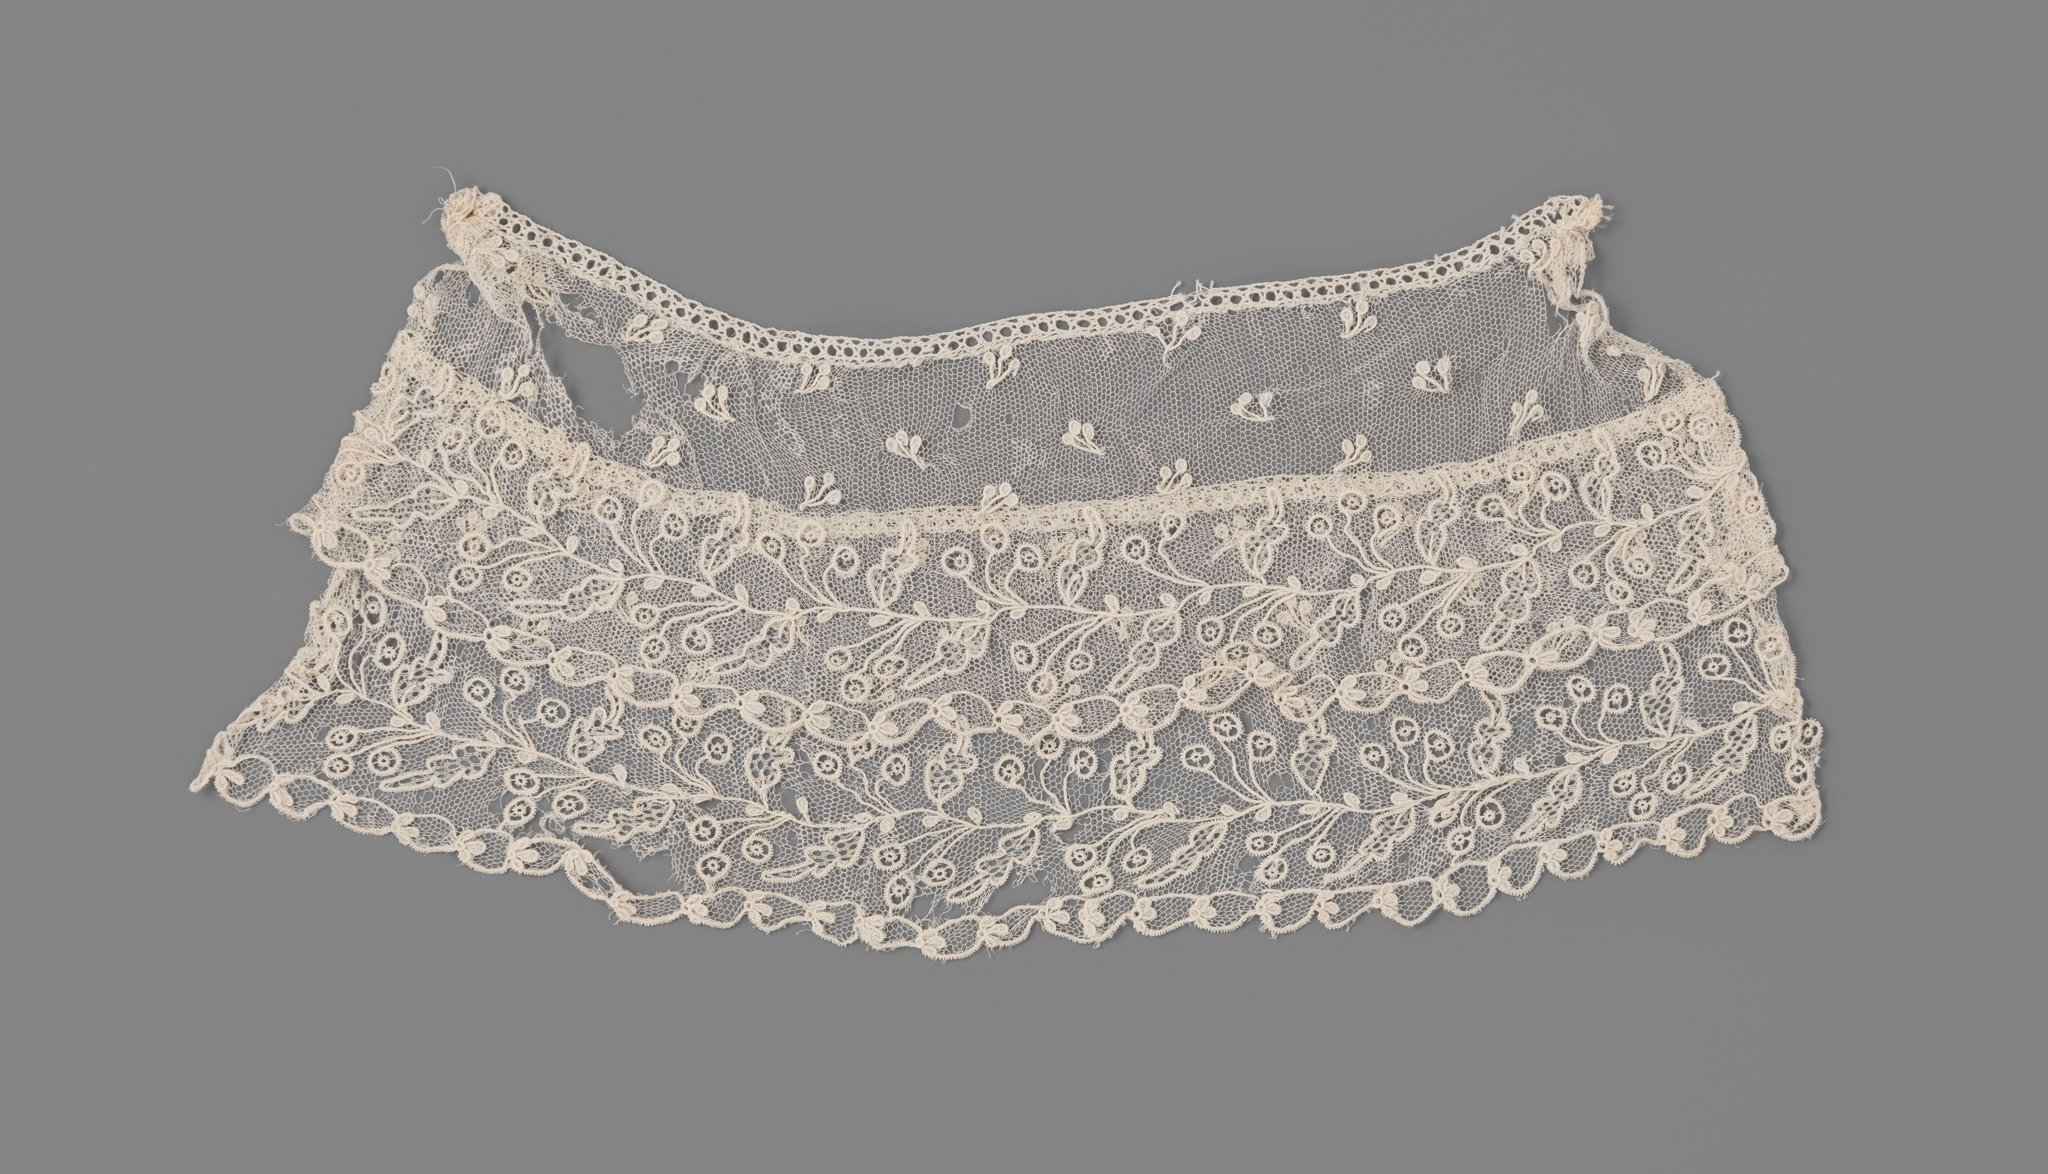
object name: menswear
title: Jabot van twee stroken naaldkant, gedecoreerd met een liggende tak met bessen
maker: Anonymous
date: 1780-1940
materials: metal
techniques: lace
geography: alençon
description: Jabot van twee stroken Alençon-kant, gedecoreerd met een liggende tak met bessen. De bovenste strook is half over de onderste strook gehecht en heeft een drukknoop in een hoek. Het patroon heeft een lopend decor liggende tak met bessen en bladeren. De onderste randen zijn geschulpt en gepicoteerd.